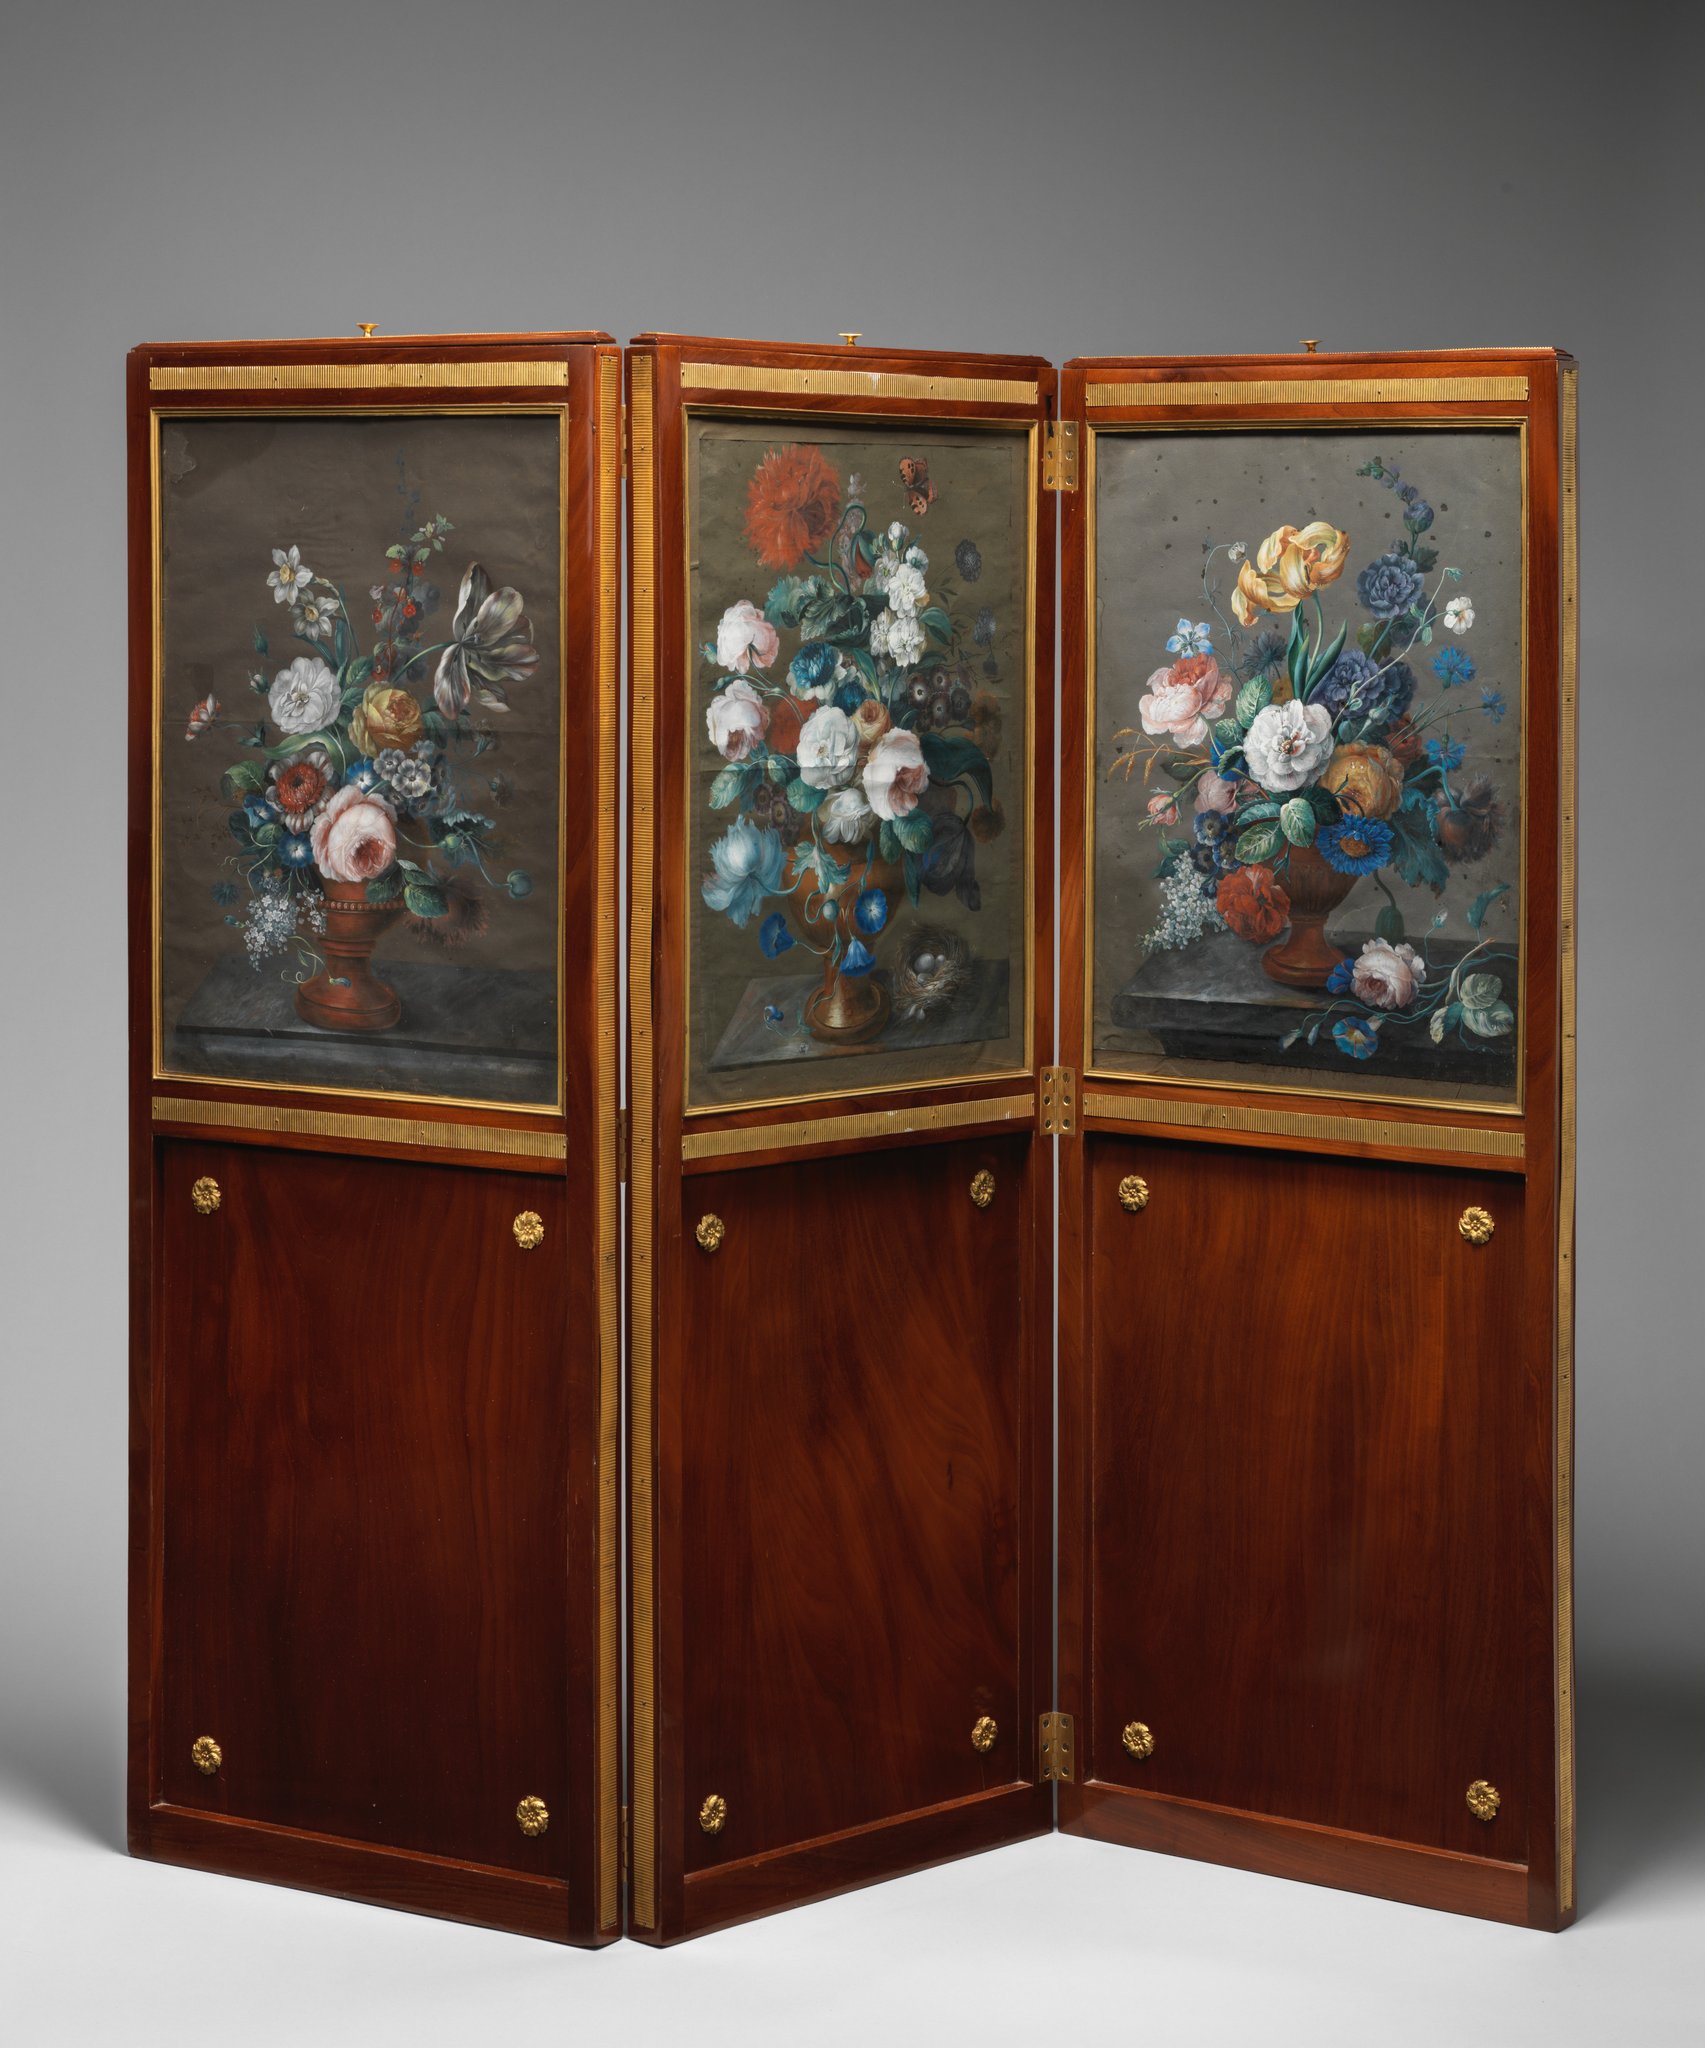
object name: screen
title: Three-leaf screen with gouache drawings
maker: johannes klinkerfuss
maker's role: maker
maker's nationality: german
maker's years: 1770-1831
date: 1801-1833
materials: gilt bronze, gouache, wood